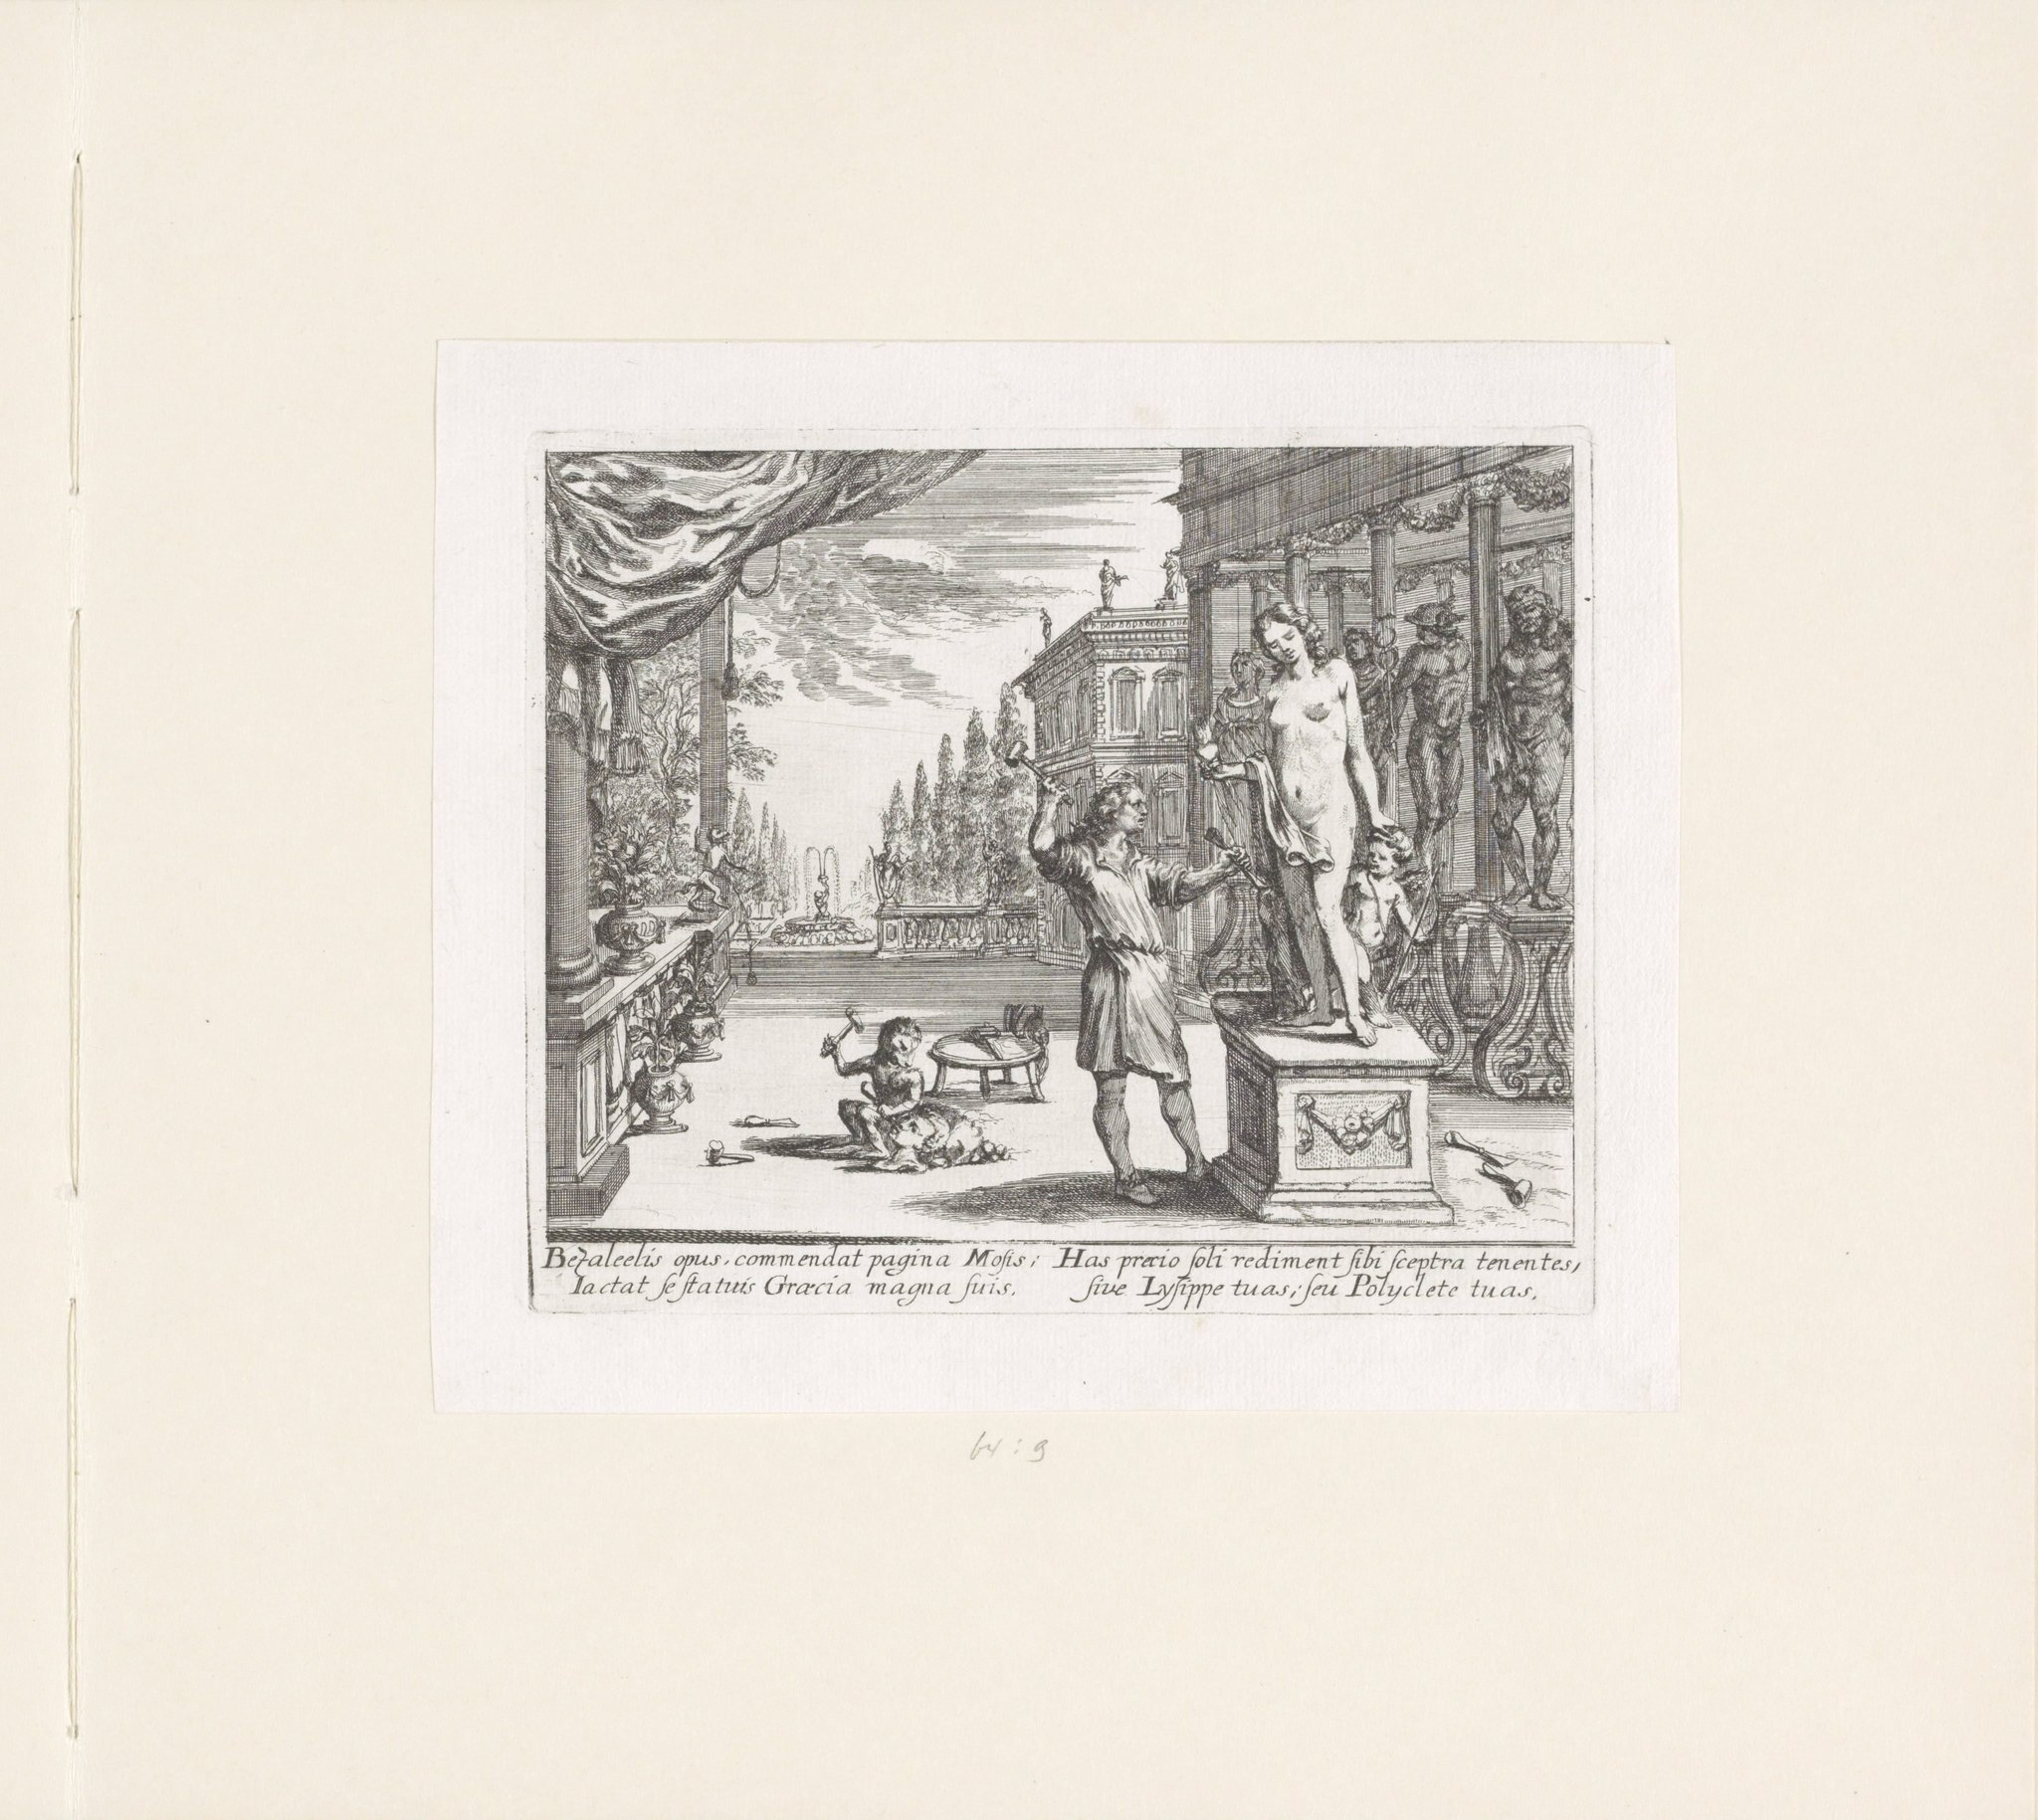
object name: album leaf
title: Beeldhouwkunst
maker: mathäus küsel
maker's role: print maker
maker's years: 1629-1681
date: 1680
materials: paper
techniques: etching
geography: augsburg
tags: sculptor at work, (story of) venus (aphrodite), tools, implements of sculptor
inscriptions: collector's mark: Lugt 964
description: Een beeldhouwer werkt aan een beeld van Venus en Amor. Rechts staan vier andere sculpturen op een sokkel, waaronder een beeld van Mercurius en van Hercules. Op de voorgrond hakt een aapje een mensenhoofd uit een steen. Onder de voorstelling vier regels tekst in het Latijn. De prent maakt deel uit van een album.